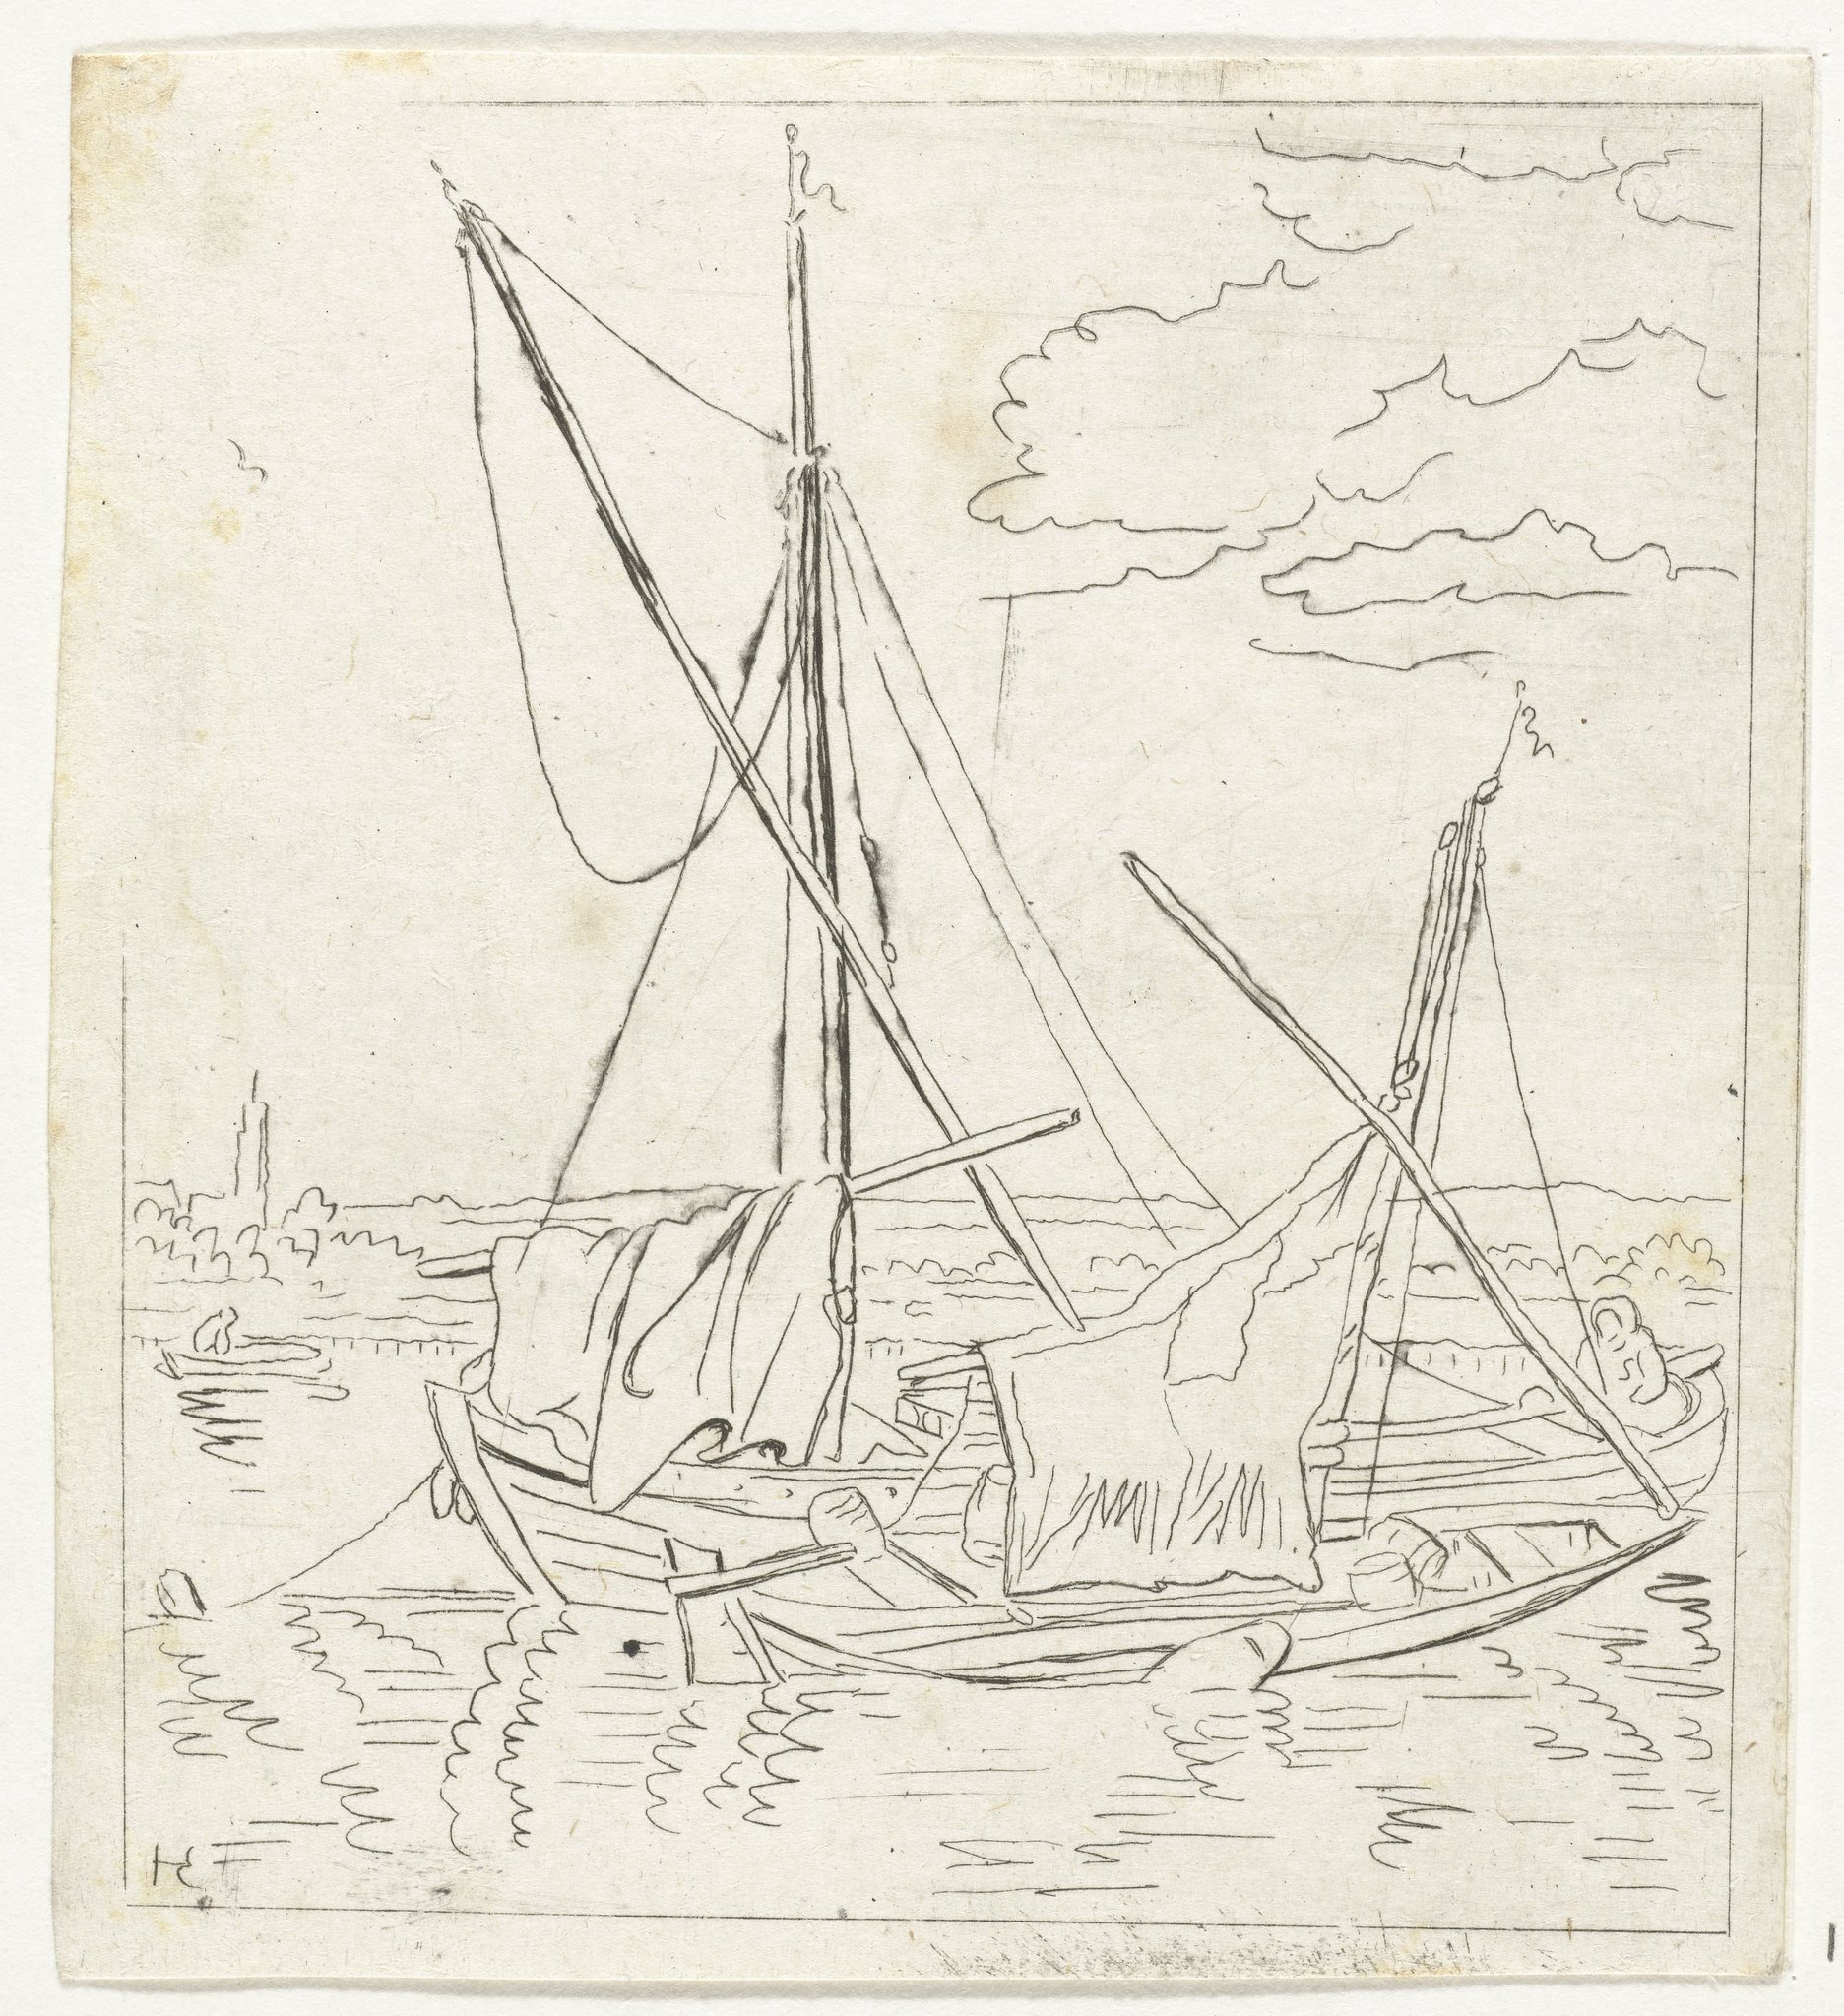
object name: print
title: Twee zeilschepen in een rivier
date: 1778-1838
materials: paper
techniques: etching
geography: netherlands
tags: sailing-ship, sailing-boat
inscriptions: collector's mark: Lugt 2228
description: Twee zeilschepen liggen naast elkaar in een rivier. In het achterste boot zit een man. Op de achtergrond is een dorp aan de oever te zien.